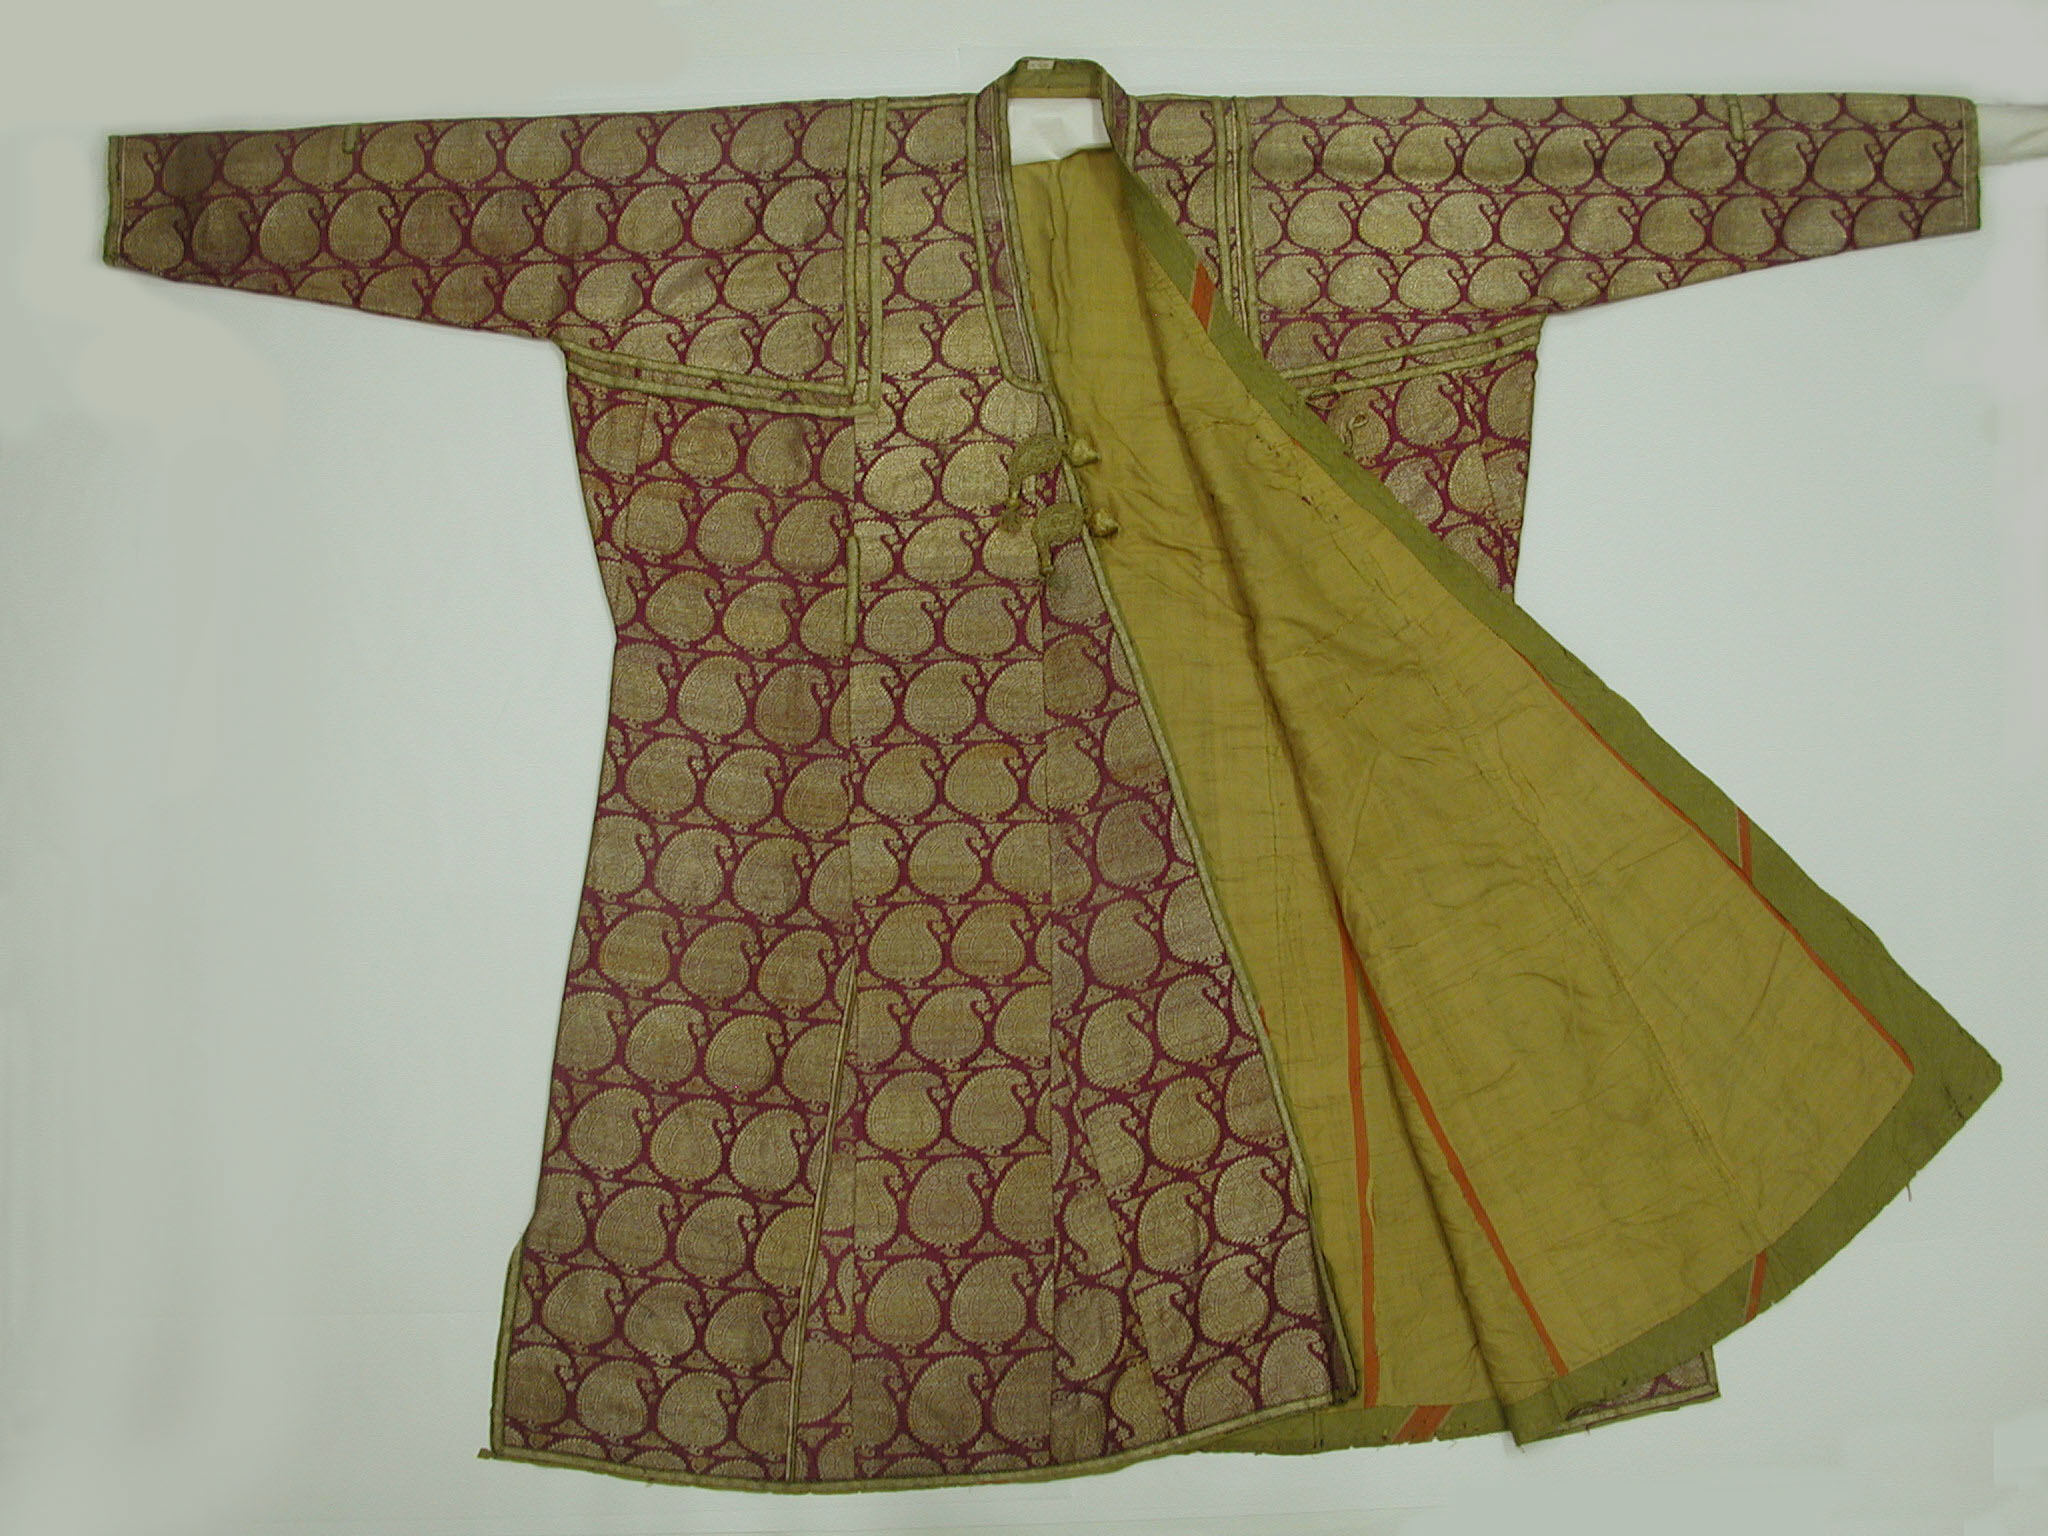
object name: coat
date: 1801-1833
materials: gold, silk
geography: india